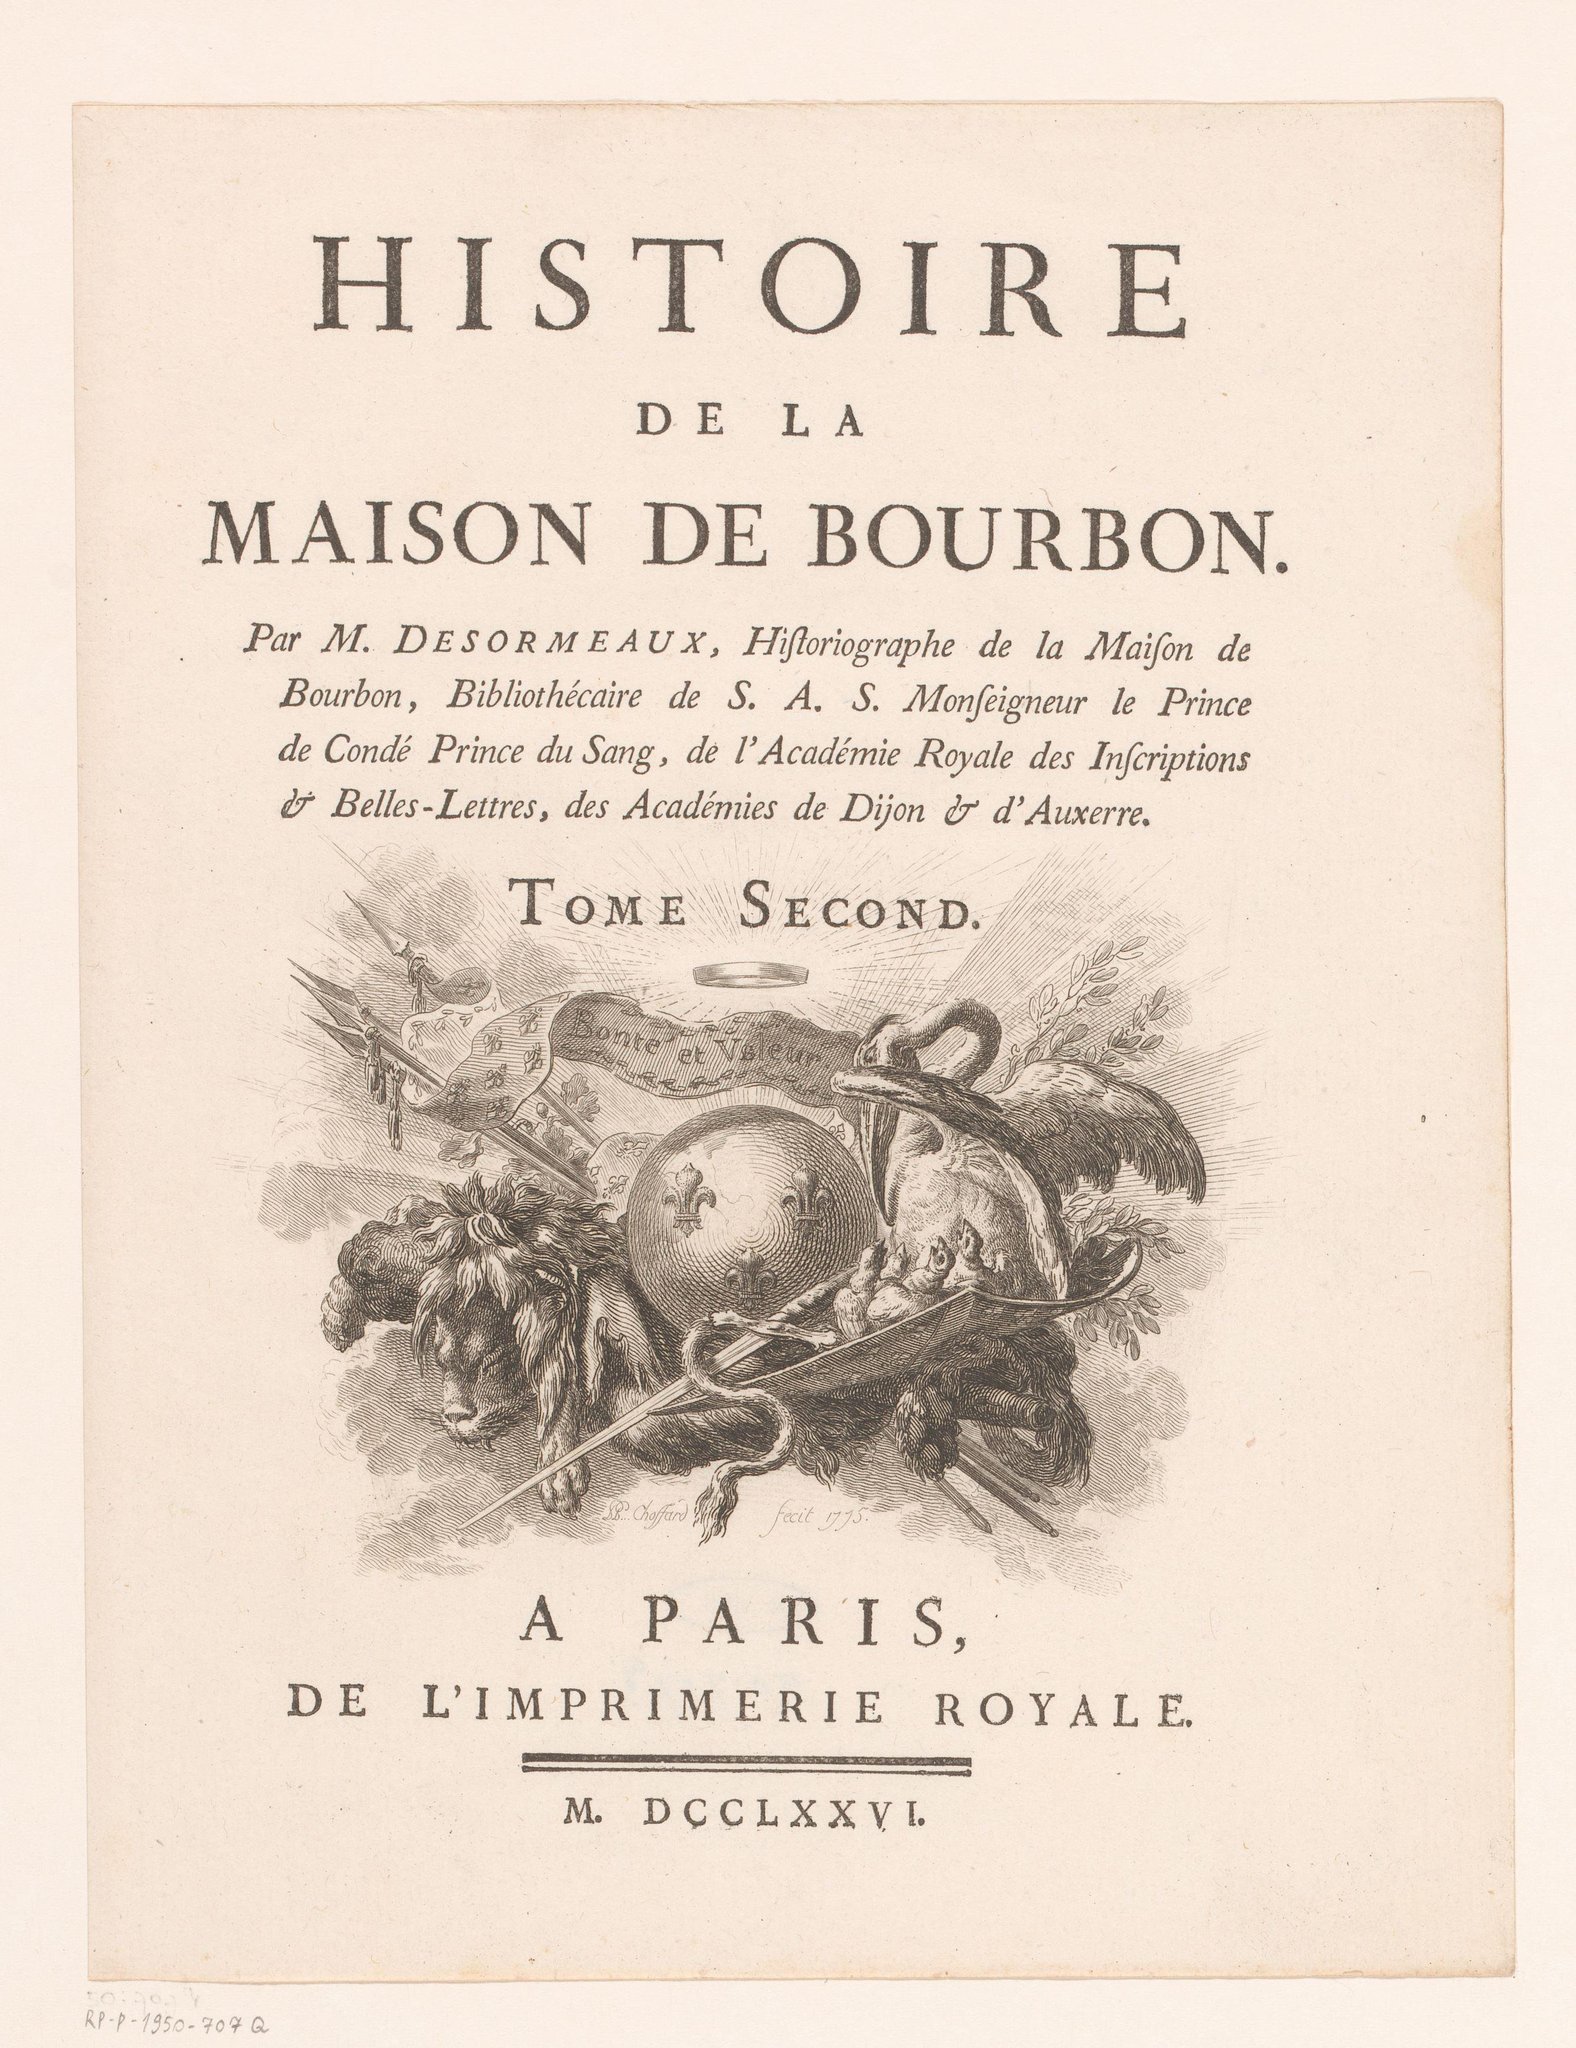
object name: titelblad, titelpagina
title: Allegorische voorstelling met pelikaan met jongen en leeuw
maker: pierre philippe choffard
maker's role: print maker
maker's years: 1730-1809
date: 1775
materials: paper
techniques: engraving, etching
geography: paris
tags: symbols of christ ~ animals, beasts of prey, predatory animals: lion, water-birds: pelican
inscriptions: collector's mark: Lugt 2228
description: Titelpagina voor: Désormeaux, Joseph-Louis-Ripault. Histoire de la maison de Bourbon. Parijs: L'imprimerie royale, 1776, dl. 2.